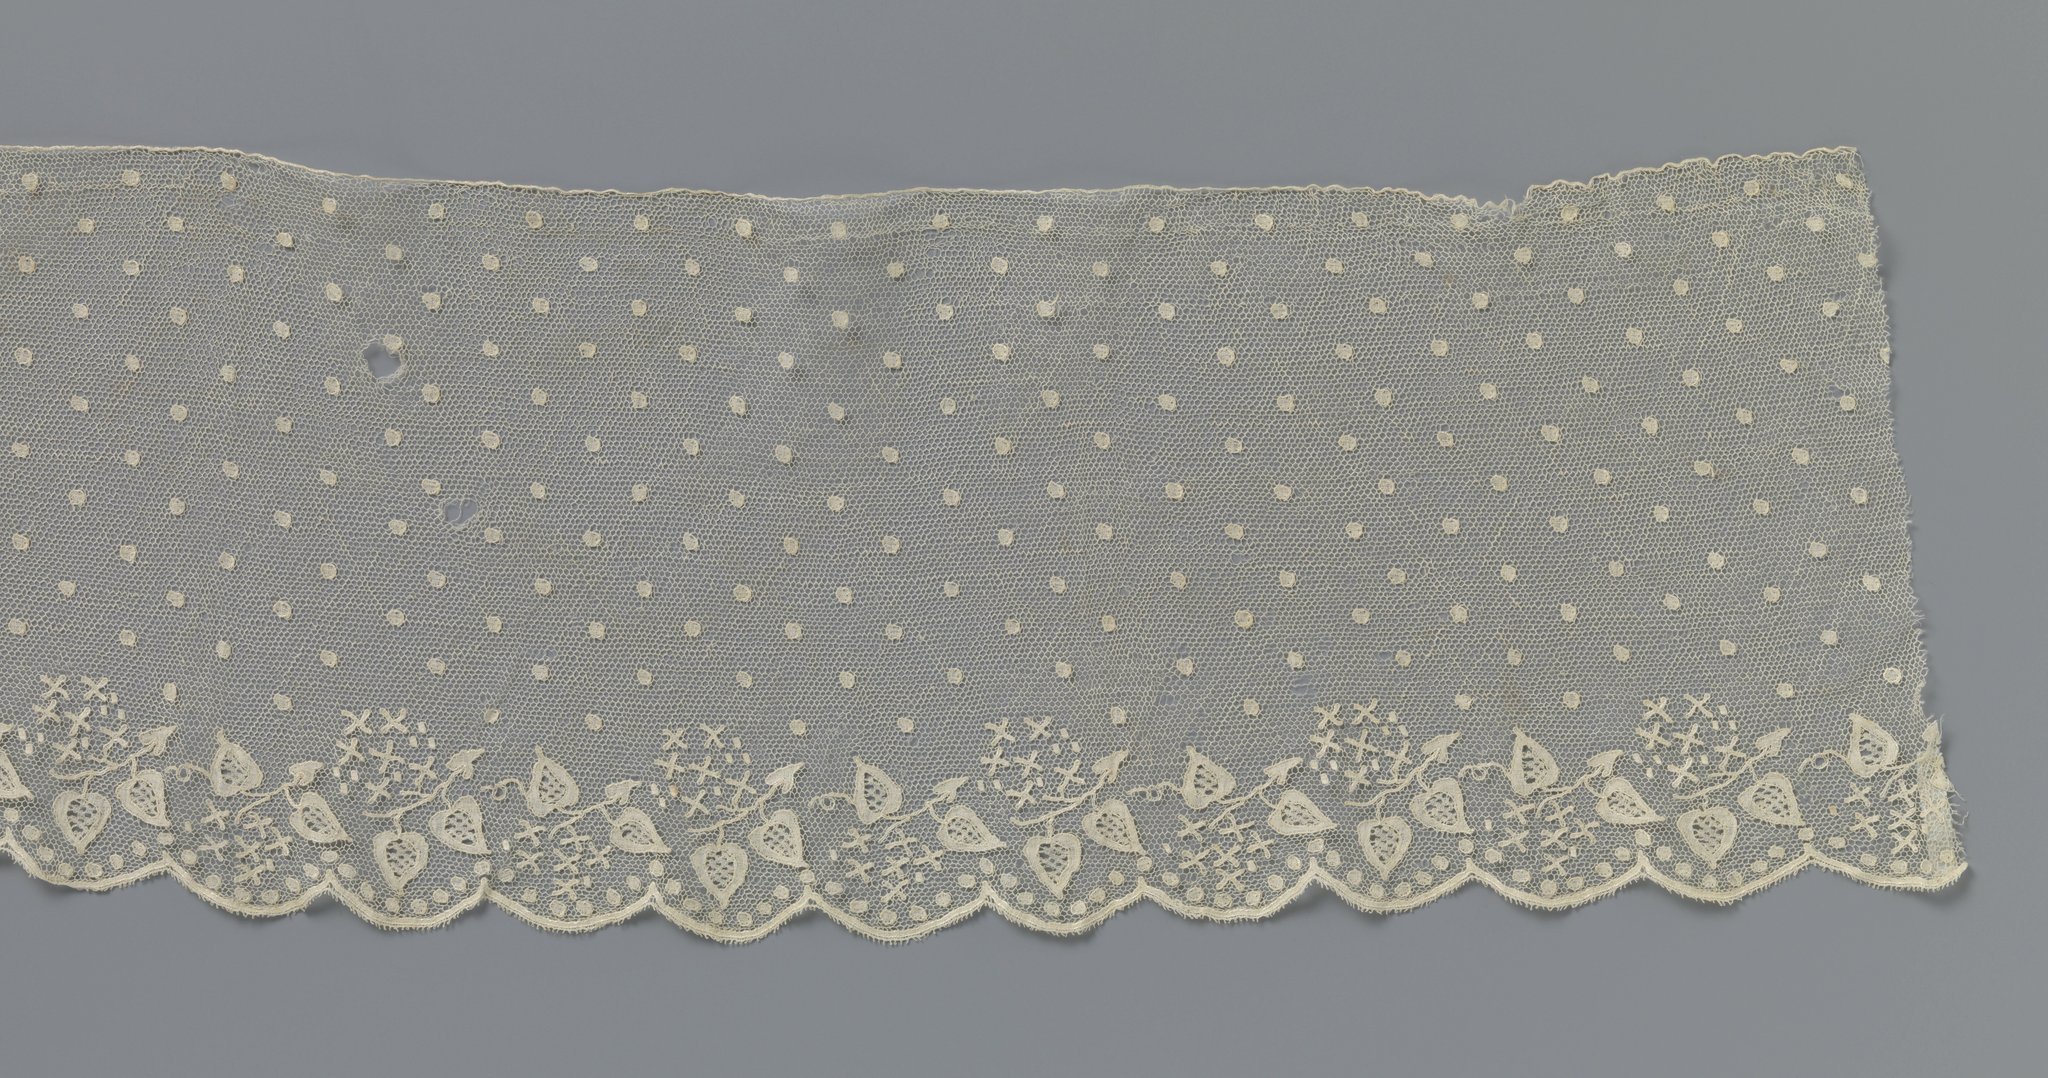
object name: strip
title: Strook kloskant met grote ronde moesjes en randpatroon met hartvormige bladeren en sneeuwballen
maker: Anonymous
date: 1800-1899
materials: silk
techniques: lace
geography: lille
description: Strook naturelkleurige kloskant: Rijselse kant. Onder een brede baan met grote ronde moesjes bestaat het zich herhalende patroon uit takjes met twee grote hartvormige bladeren en één klein hartvormig blaadje, in twee variaties. Een patroontje van kruisjes en vierkante moesjes bevindt zich afwisselend onder en boven de takjes en stelt mogelijk een sneeuwbal voor (bloem). Langs de halfronde schulpen loopt een dubbele rand van een bandje en losse ronde moesjes. De motieven zijn met elkaar verbonden door een fijne traliegrond, een tulegrond. De motieven zijn gemaakt in linnenslag met dikkere, glimmende contourdraden. In het centrum van de grote bladeren is één soort siergrond toegepast. De vierkante moesjes in de sneeuwbal zijn gemaakt in vormslag. De bovenzijde van de strook is recht afgewerkt. De schulpen langs de onderzijde zijn afgewerkt met picots.